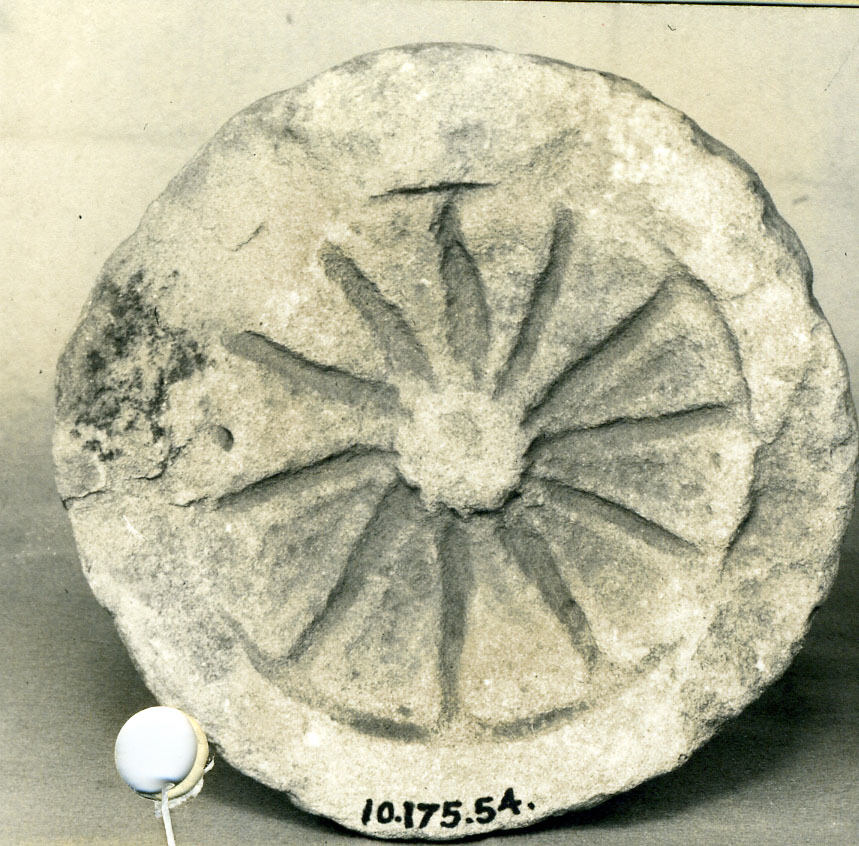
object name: bos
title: Boss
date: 201-1200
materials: stone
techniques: carving, relief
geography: egypt